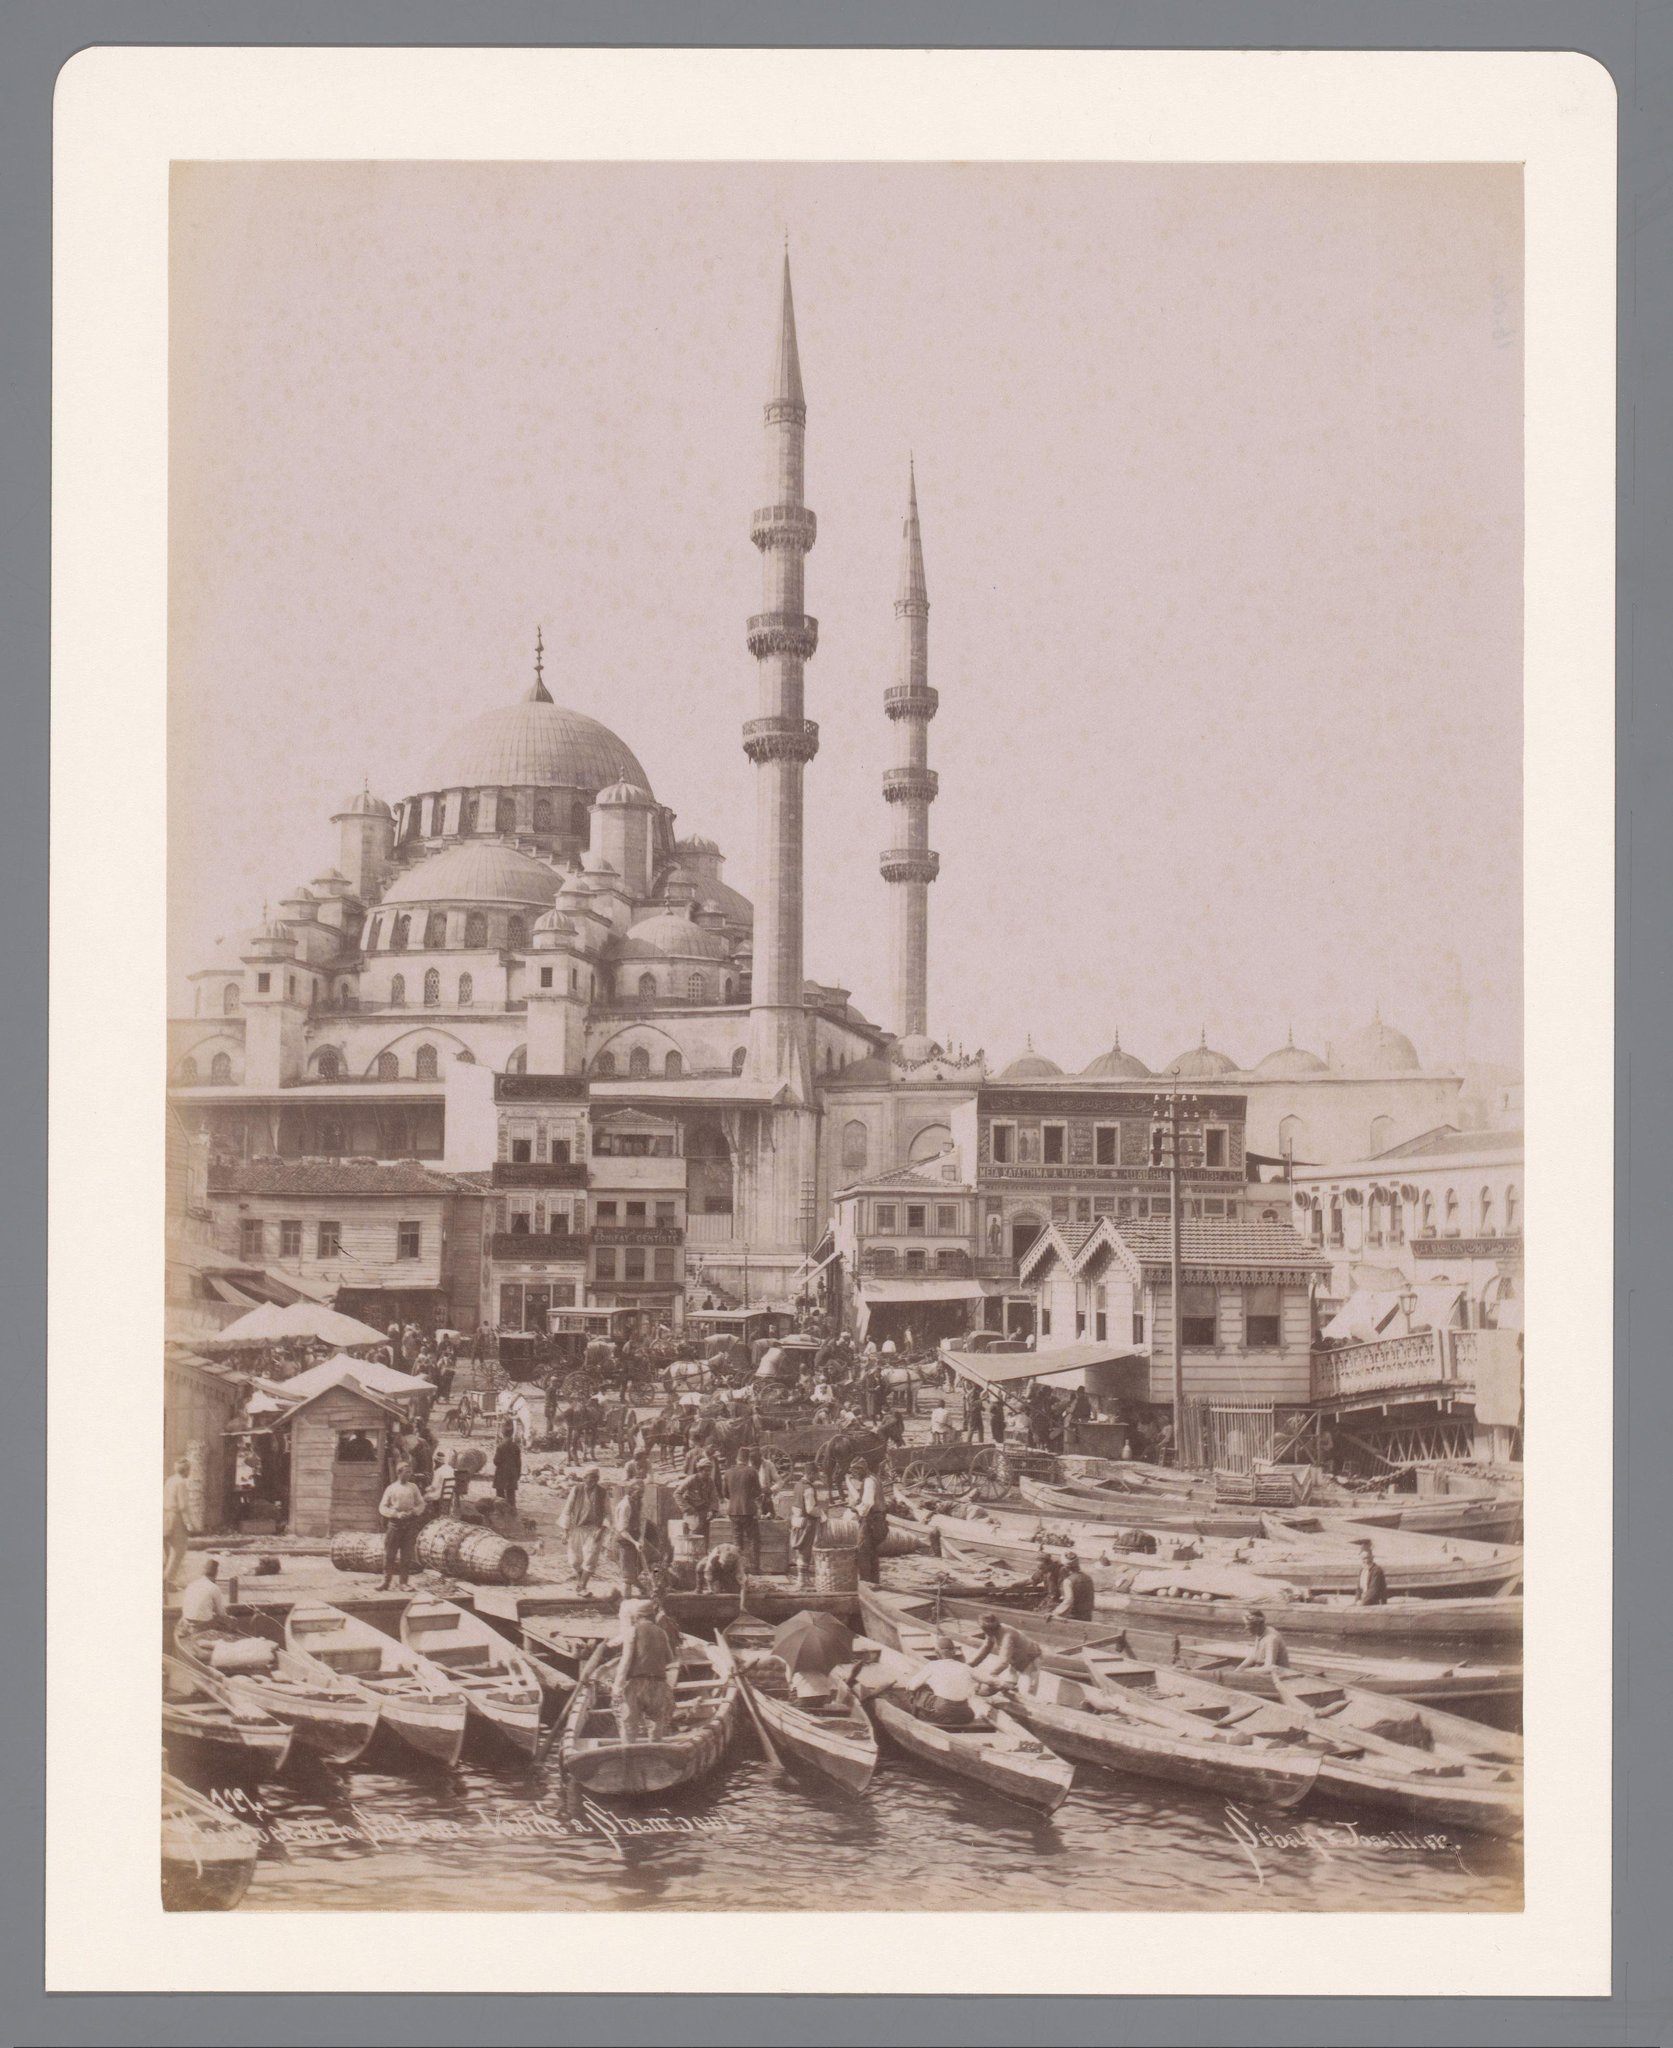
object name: photograph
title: Mosquée de la Sultane Validé a Stamboul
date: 1888-1900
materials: paper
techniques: albumen print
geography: istanbul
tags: temple, shrine ~ islam, mohammedanism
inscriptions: number: ‘112’